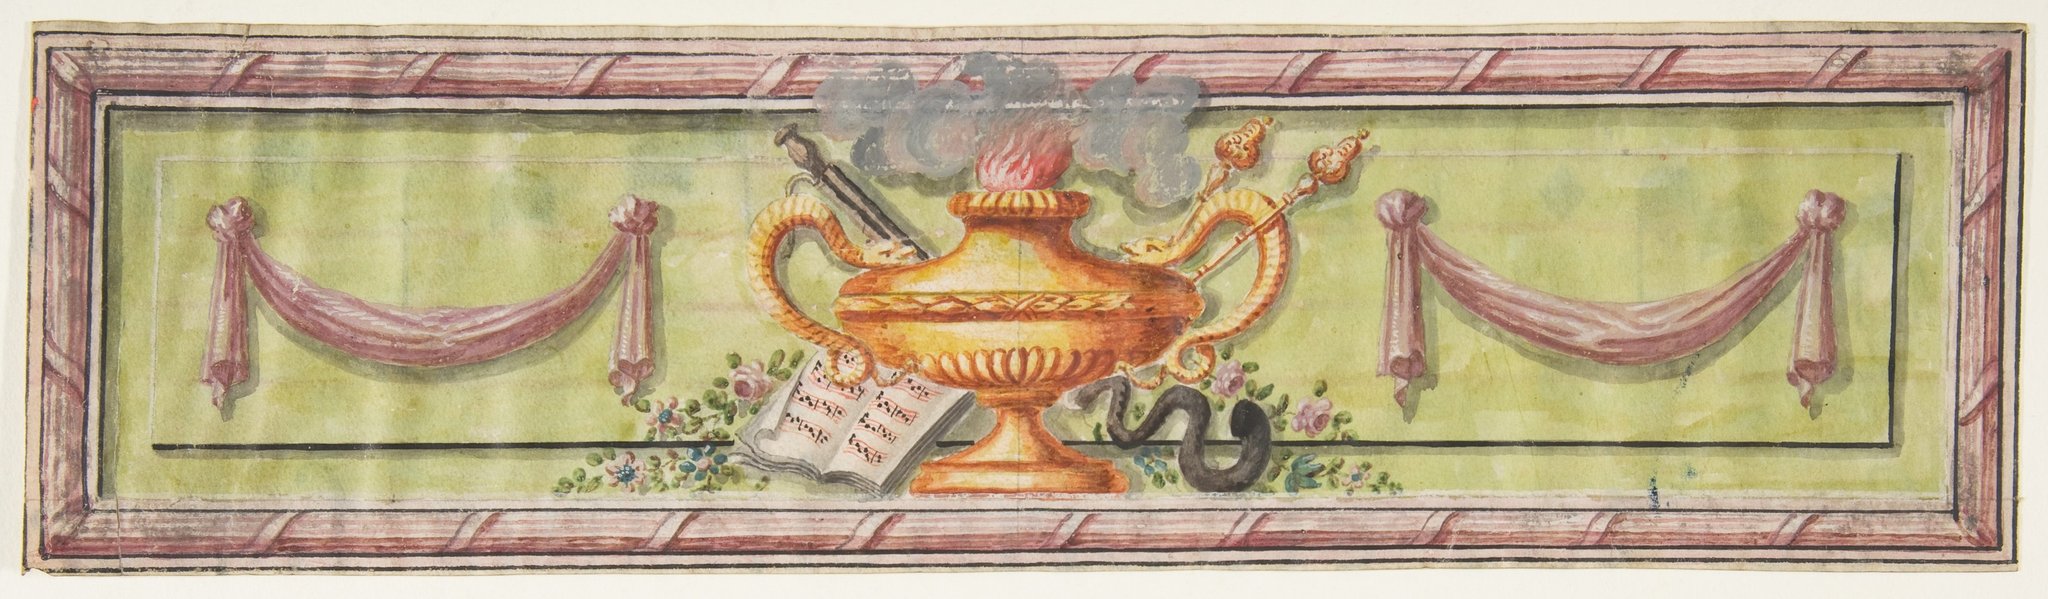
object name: drawing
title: Ornamental Panel with Flaming Lamps and Sheet Music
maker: anonymous, french, 19th century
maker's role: artist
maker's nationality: french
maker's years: 1800-1900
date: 1801-1900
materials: parchment, watercolor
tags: music,snakes